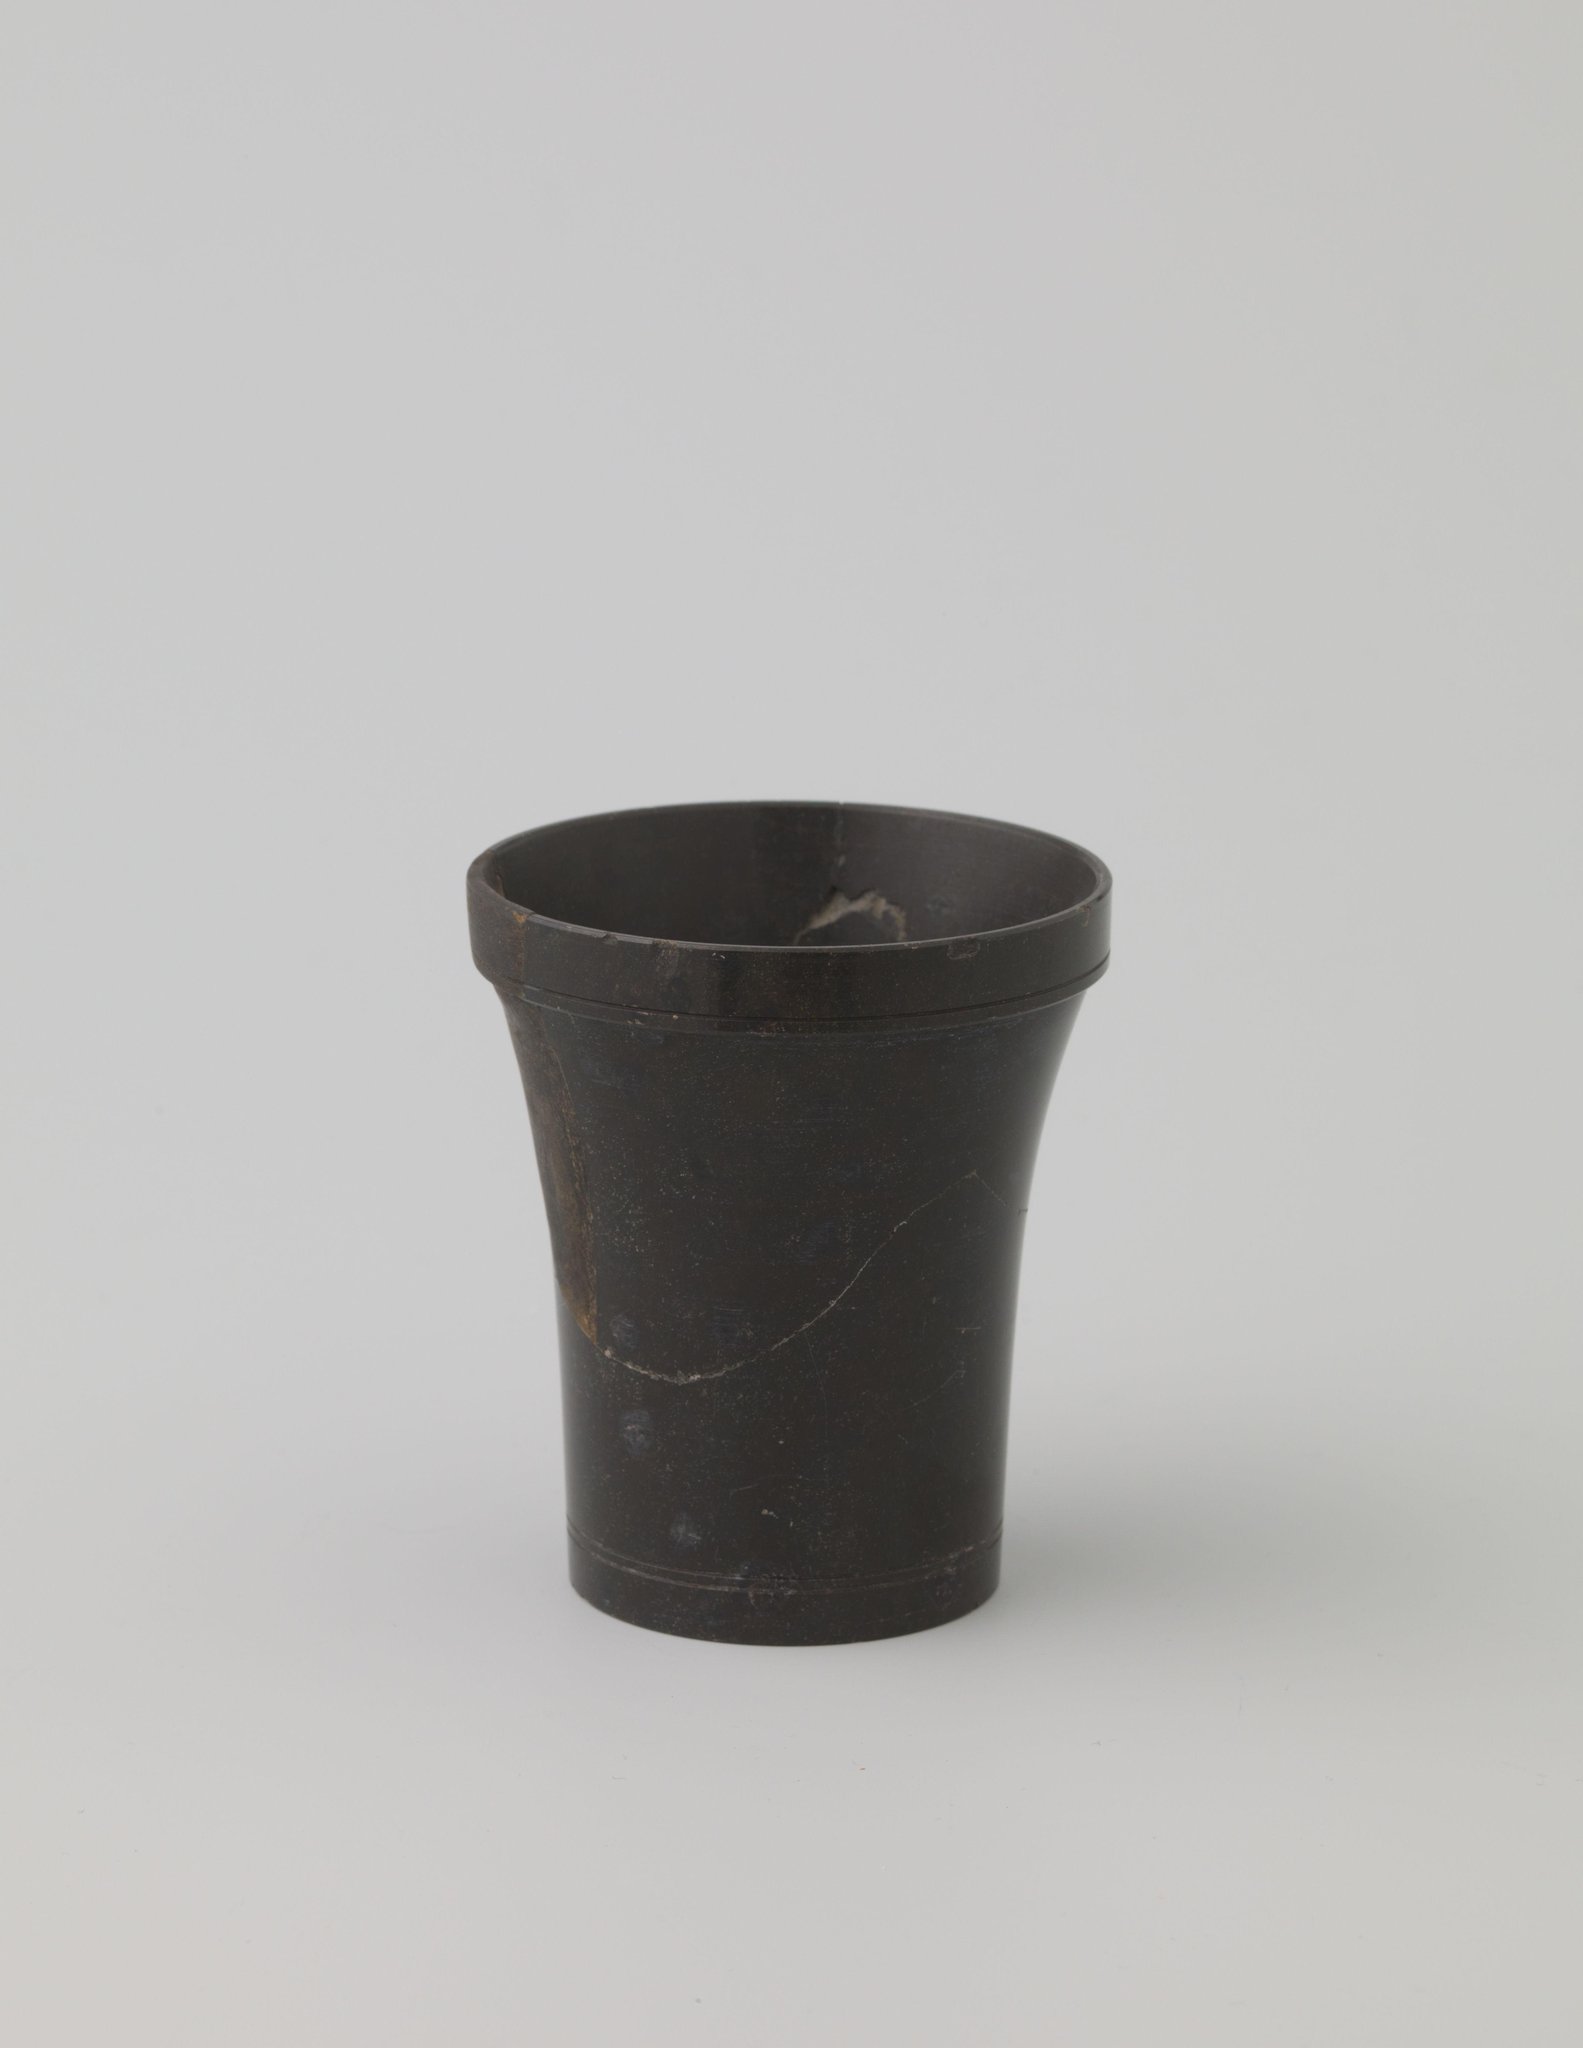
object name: cup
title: Beker van serpentijnsteen.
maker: Anonymous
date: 1400-1950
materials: stone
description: Beker van groen marmer (serpentijnsteen) gegeven door Luvart van de Becken (?), Bisschop van Antwerpen aan de vaders Jezuiten te Leuven in 1572. (Ook vermeld lijst Z-36)